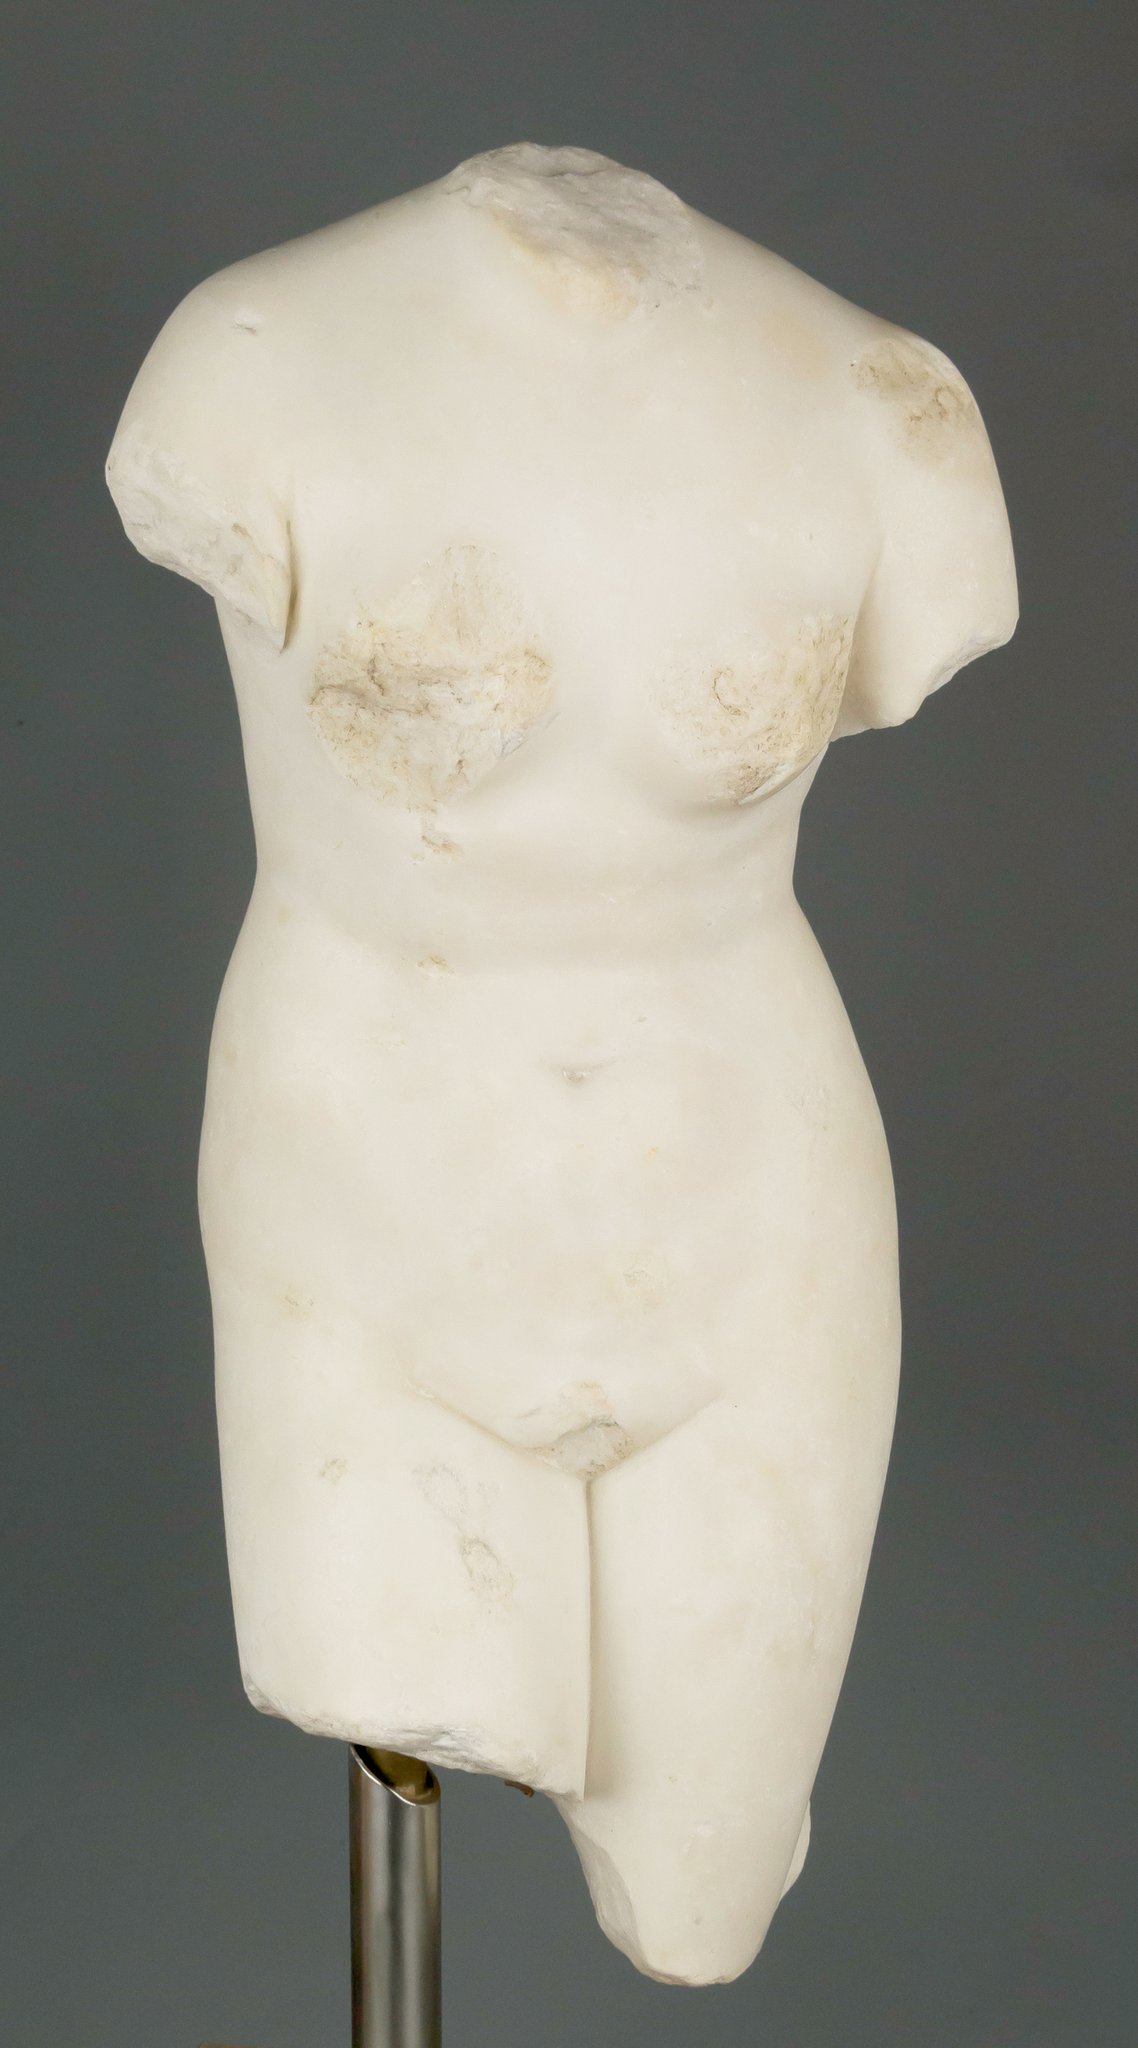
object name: statuette of aphrodite, capitoline type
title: Marble statue of Aphrodite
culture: roman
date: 1-200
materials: marble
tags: aphrodite